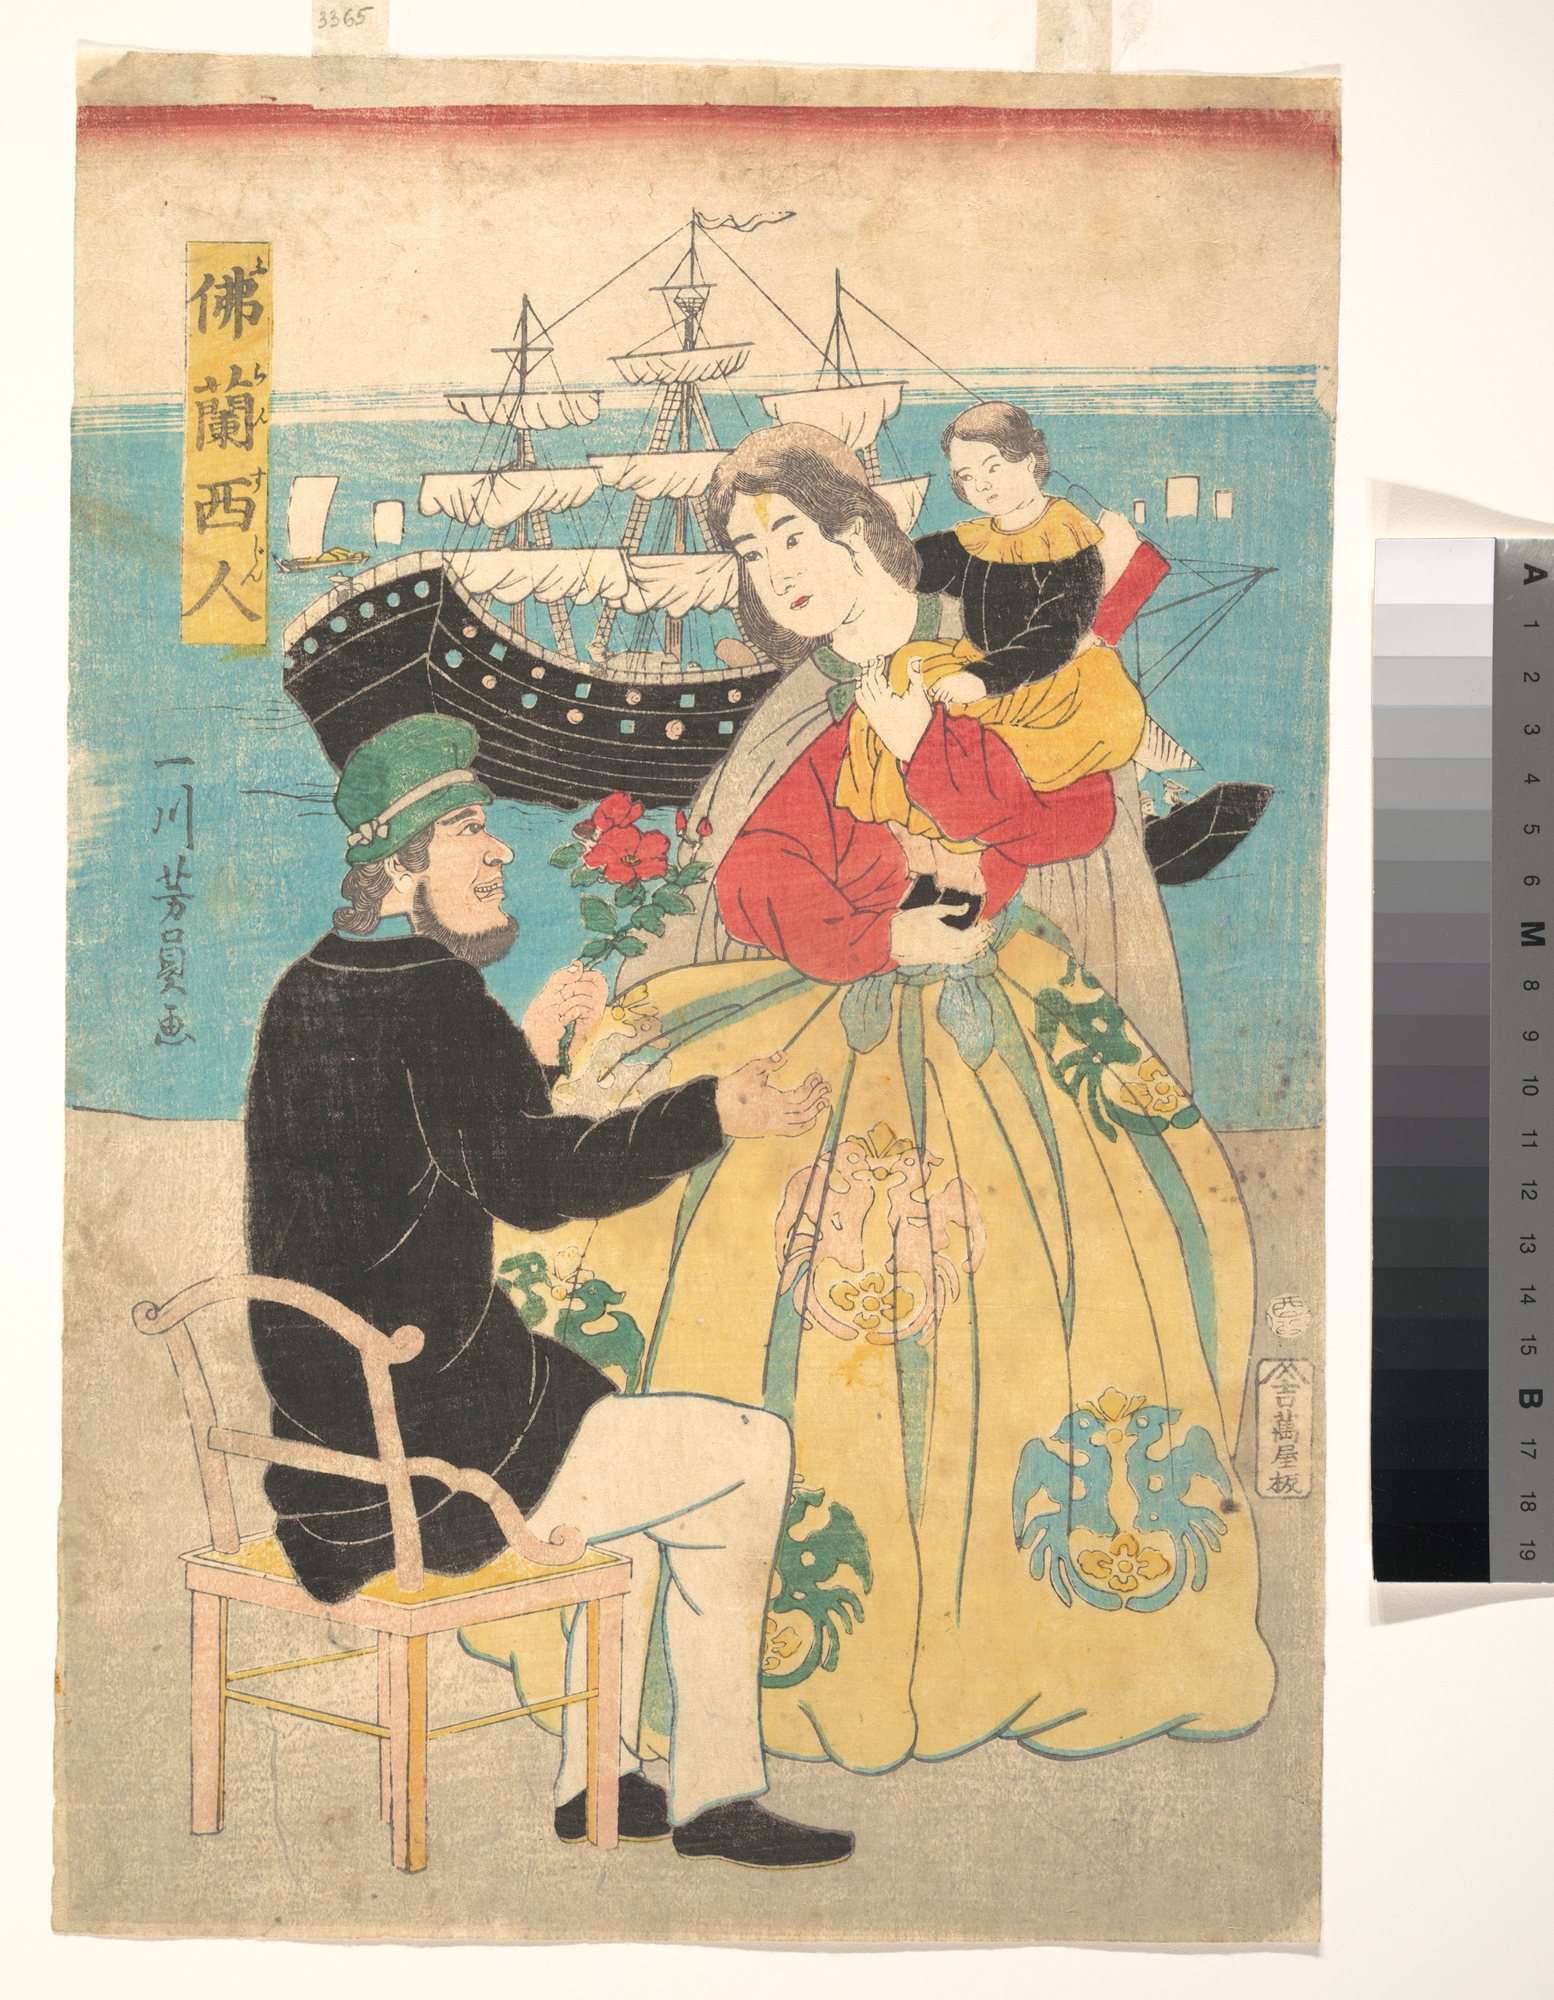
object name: print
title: Furansujin (Frenchman)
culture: japanese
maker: utagawa yoshikazu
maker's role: artist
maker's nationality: japanese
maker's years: 1845-1870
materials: ink, paper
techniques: woodblock print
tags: girls,men,women,ships,chairs